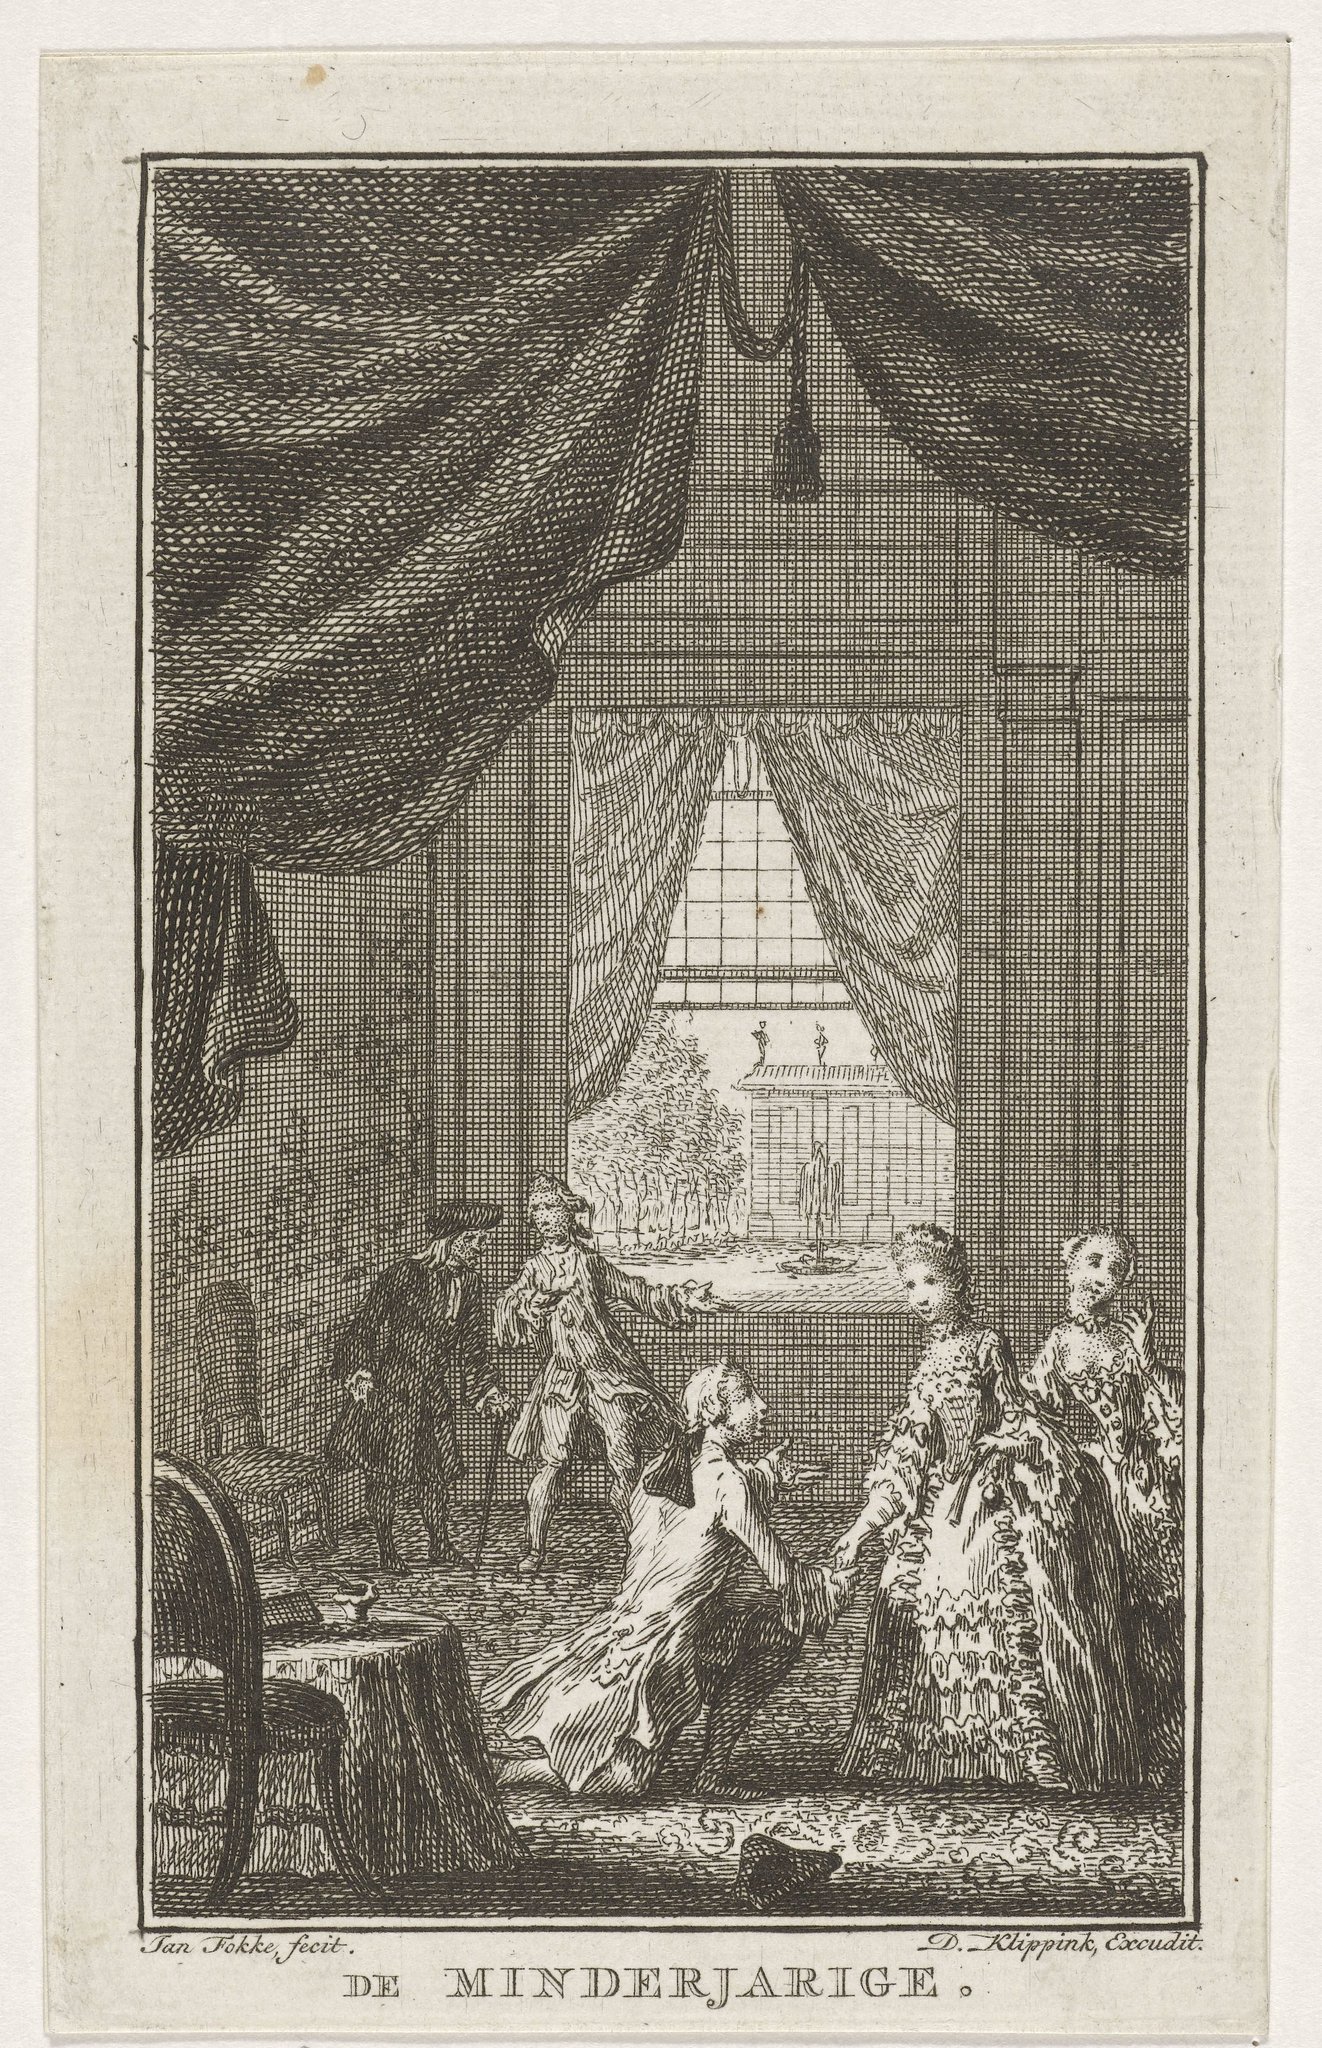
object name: print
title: Jongeman knielt voor meisje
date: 1758-1812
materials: paper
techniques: etching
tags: kneeling figure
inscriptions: collector's mark: Lugt 2228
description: In een kamer knielt een jongman voor een meisje. Deze prent is mogelijk vervaardigd voor het blijspel "De minderjarige" (1758) van Jan Jacob Hartsinck.